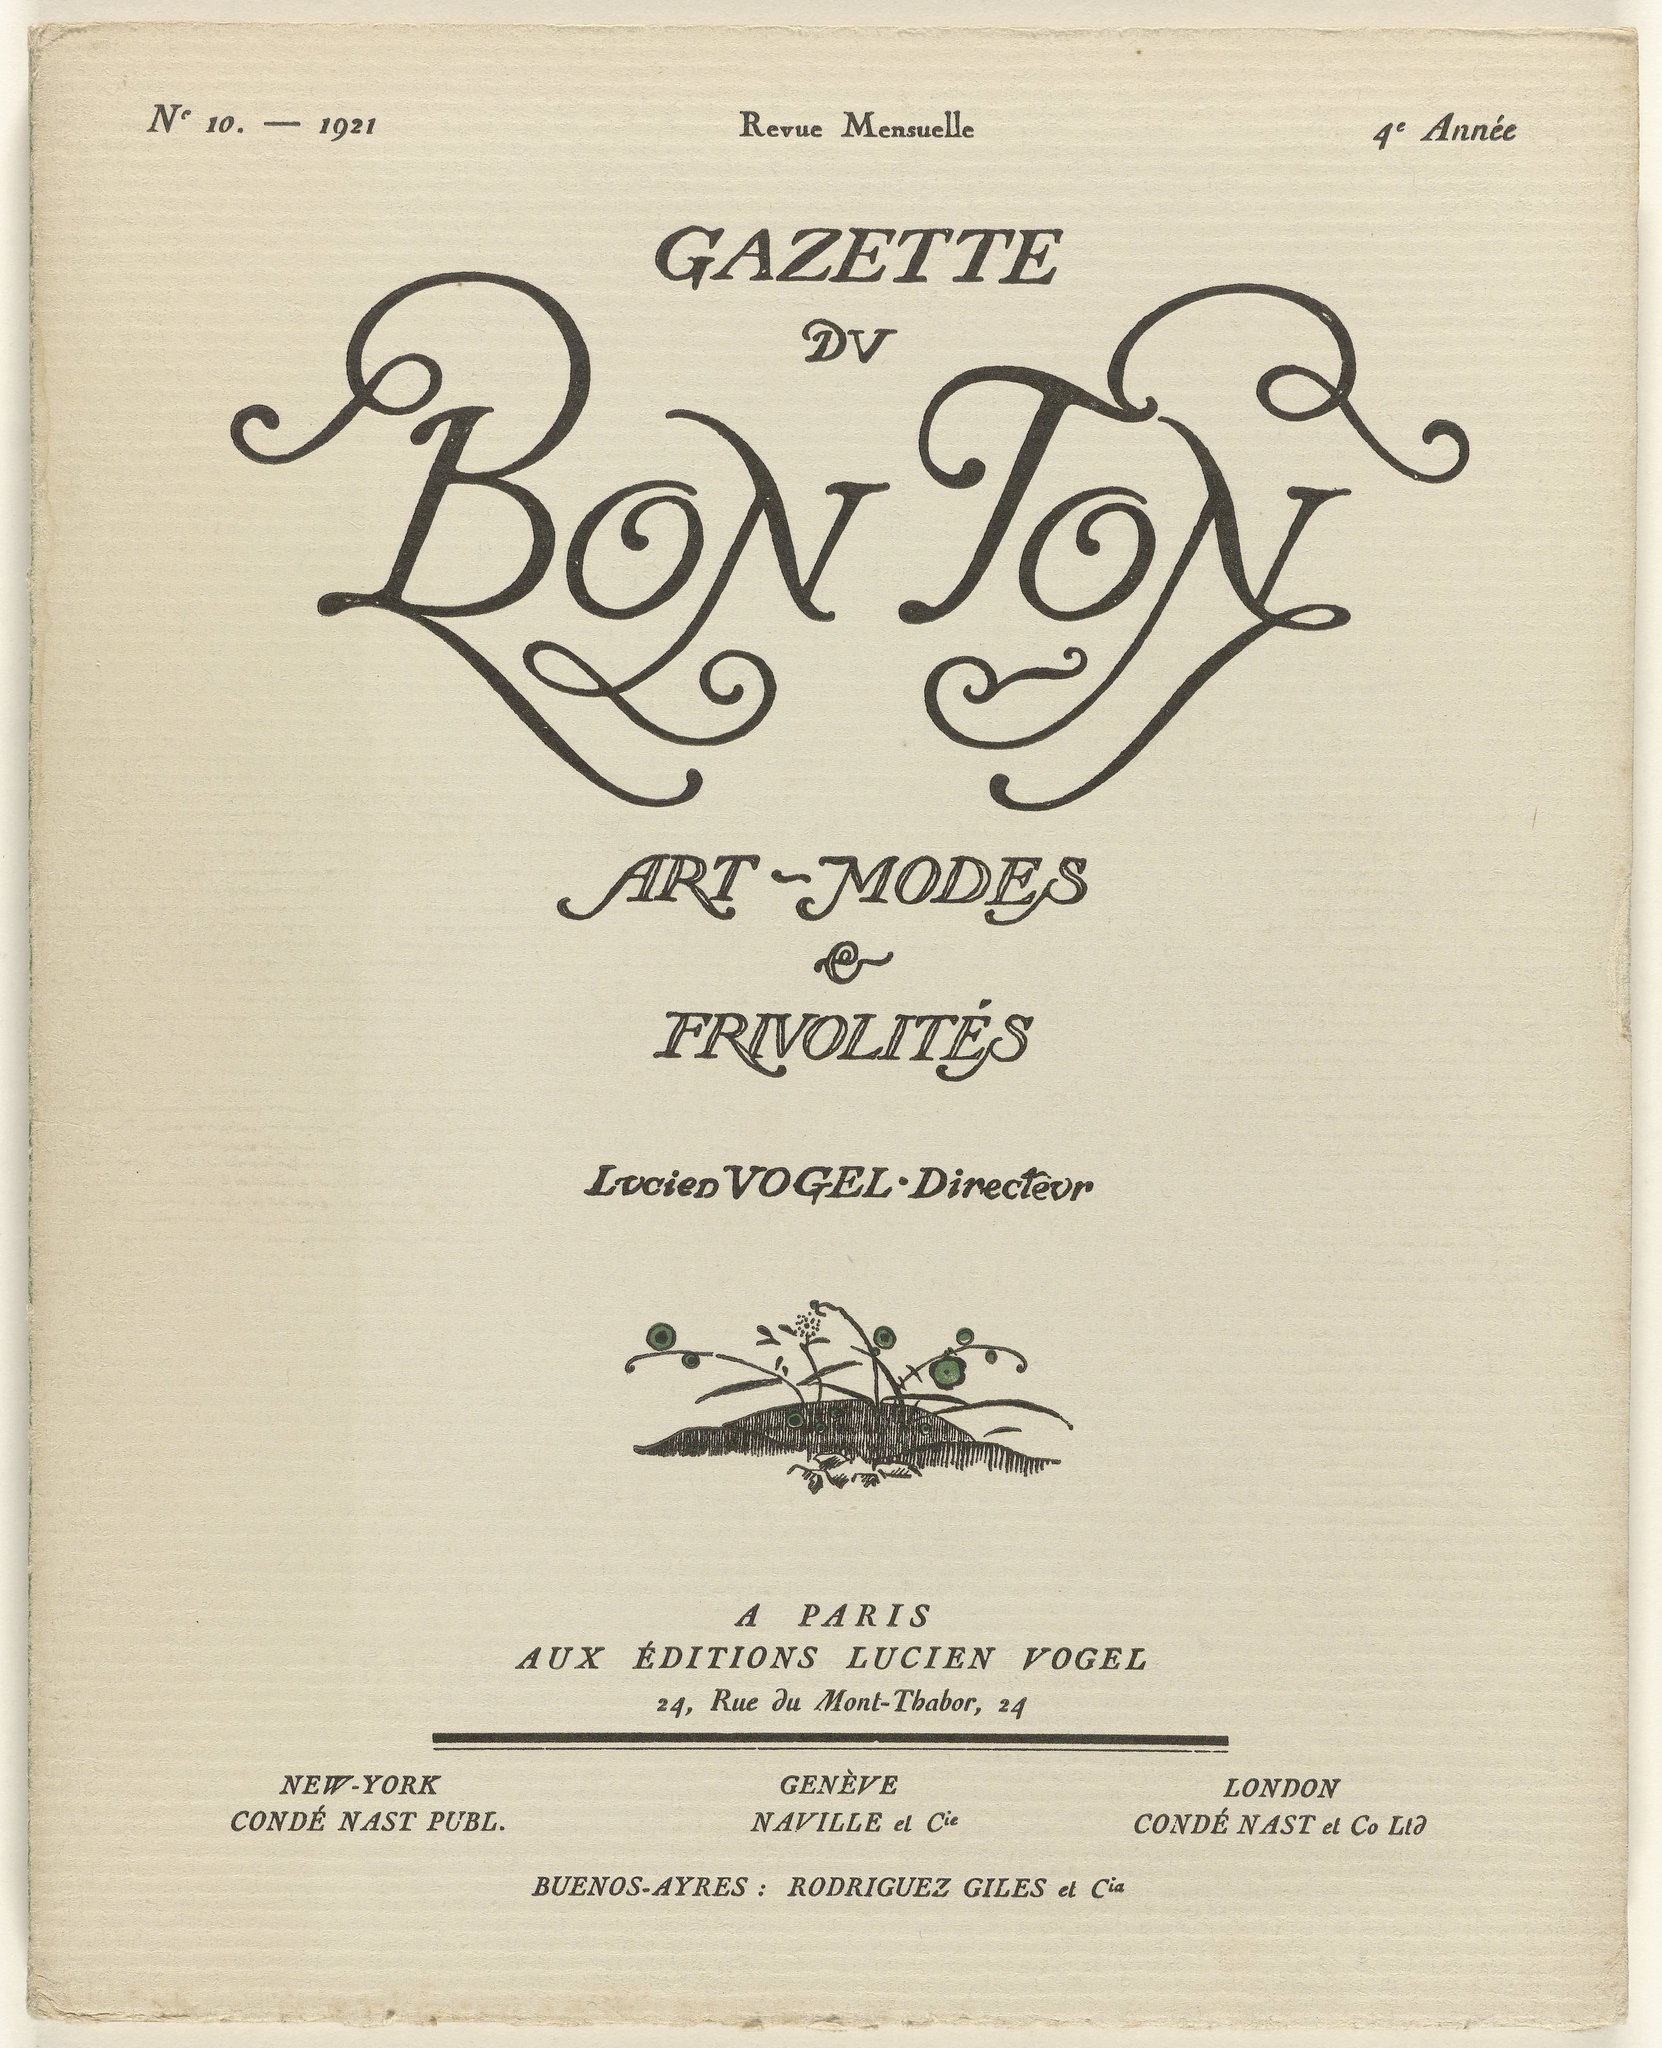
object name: fashion print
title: Gazette du Bon Ton. Art - Modes & Frivolités, No. 10 - 1921, 4e Année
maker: lucien vogel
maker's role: publisher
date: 1921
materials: paper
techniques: letterpress printing, pochoir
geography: geneva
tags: fashion plates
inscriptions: date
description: Aflevering no. 10, december 1921, van Gazette du Bon Ton, bestaand uit een omslag, tien katernen met tekst en illustraties en zestien losse prenten. Aan dit deel werkten de volgende modeontwerpers mee: Beer, Doeuillet, Lanvin, Paul Poiret, Camille Roger, Vionnet en Worth.